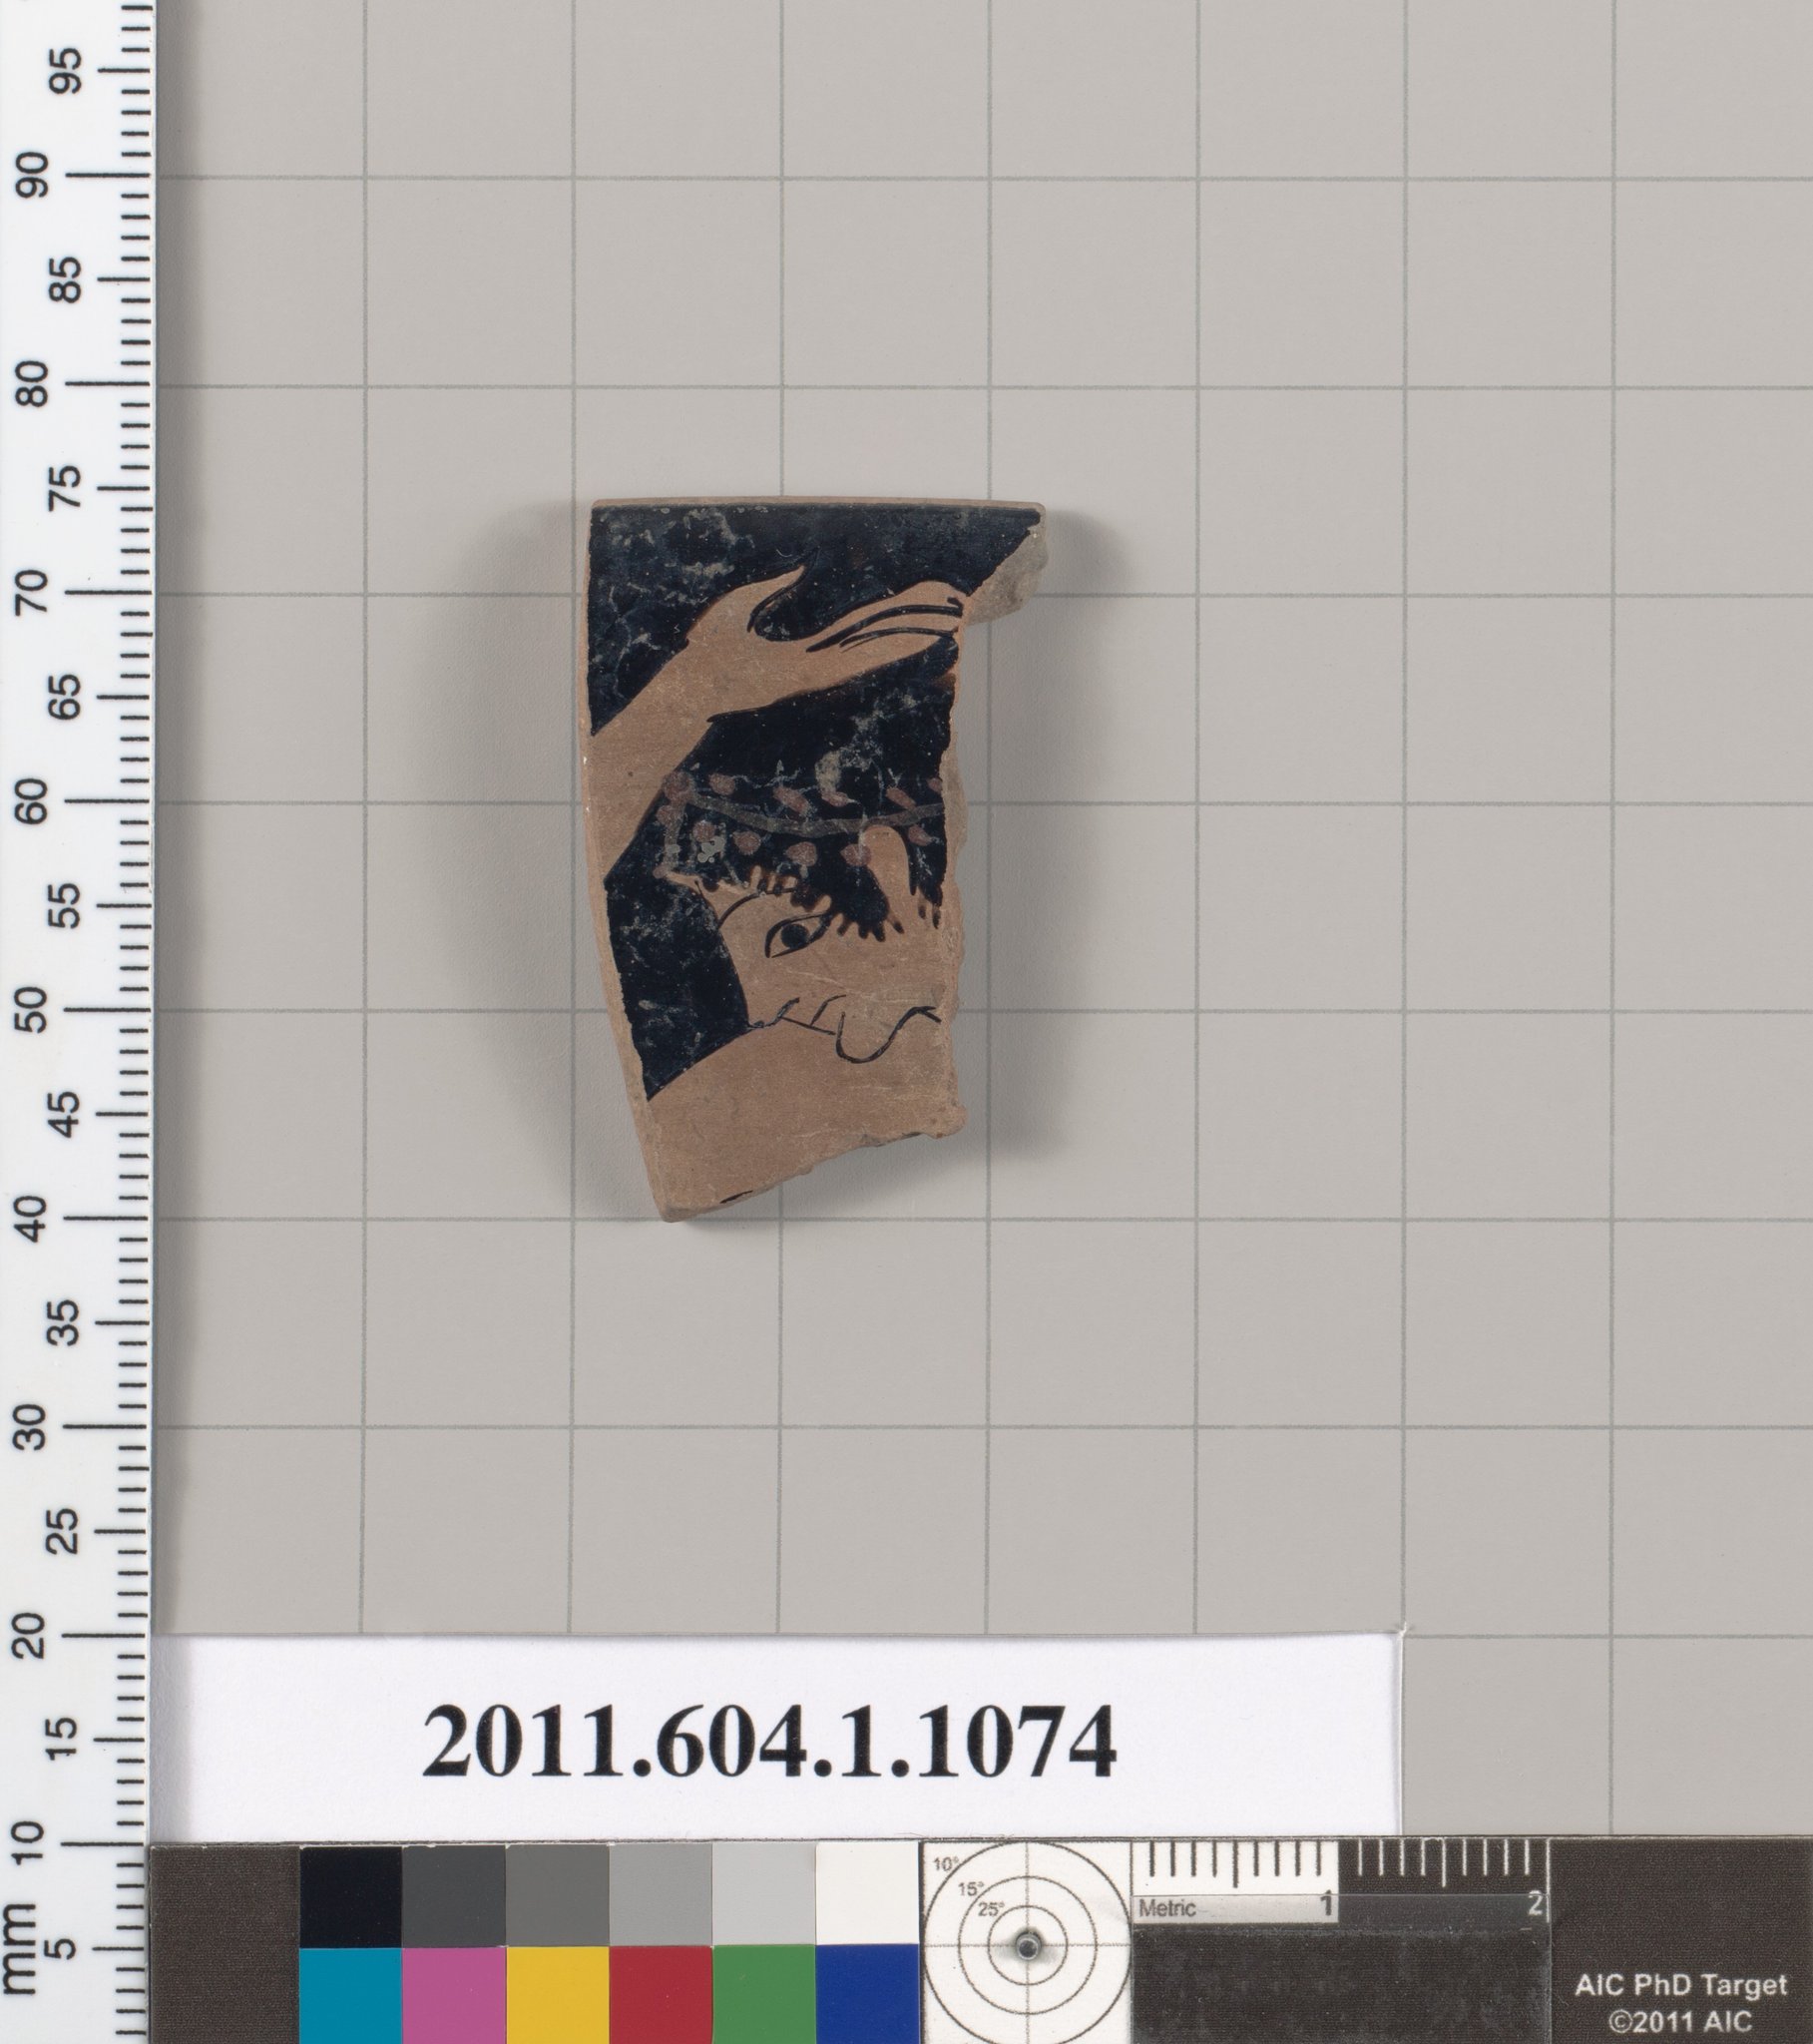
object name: kylix fragment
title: Terracotta rim fragment of a kylix (drinking cup)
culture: greek, attic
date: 510-500 BCE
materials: terracotta